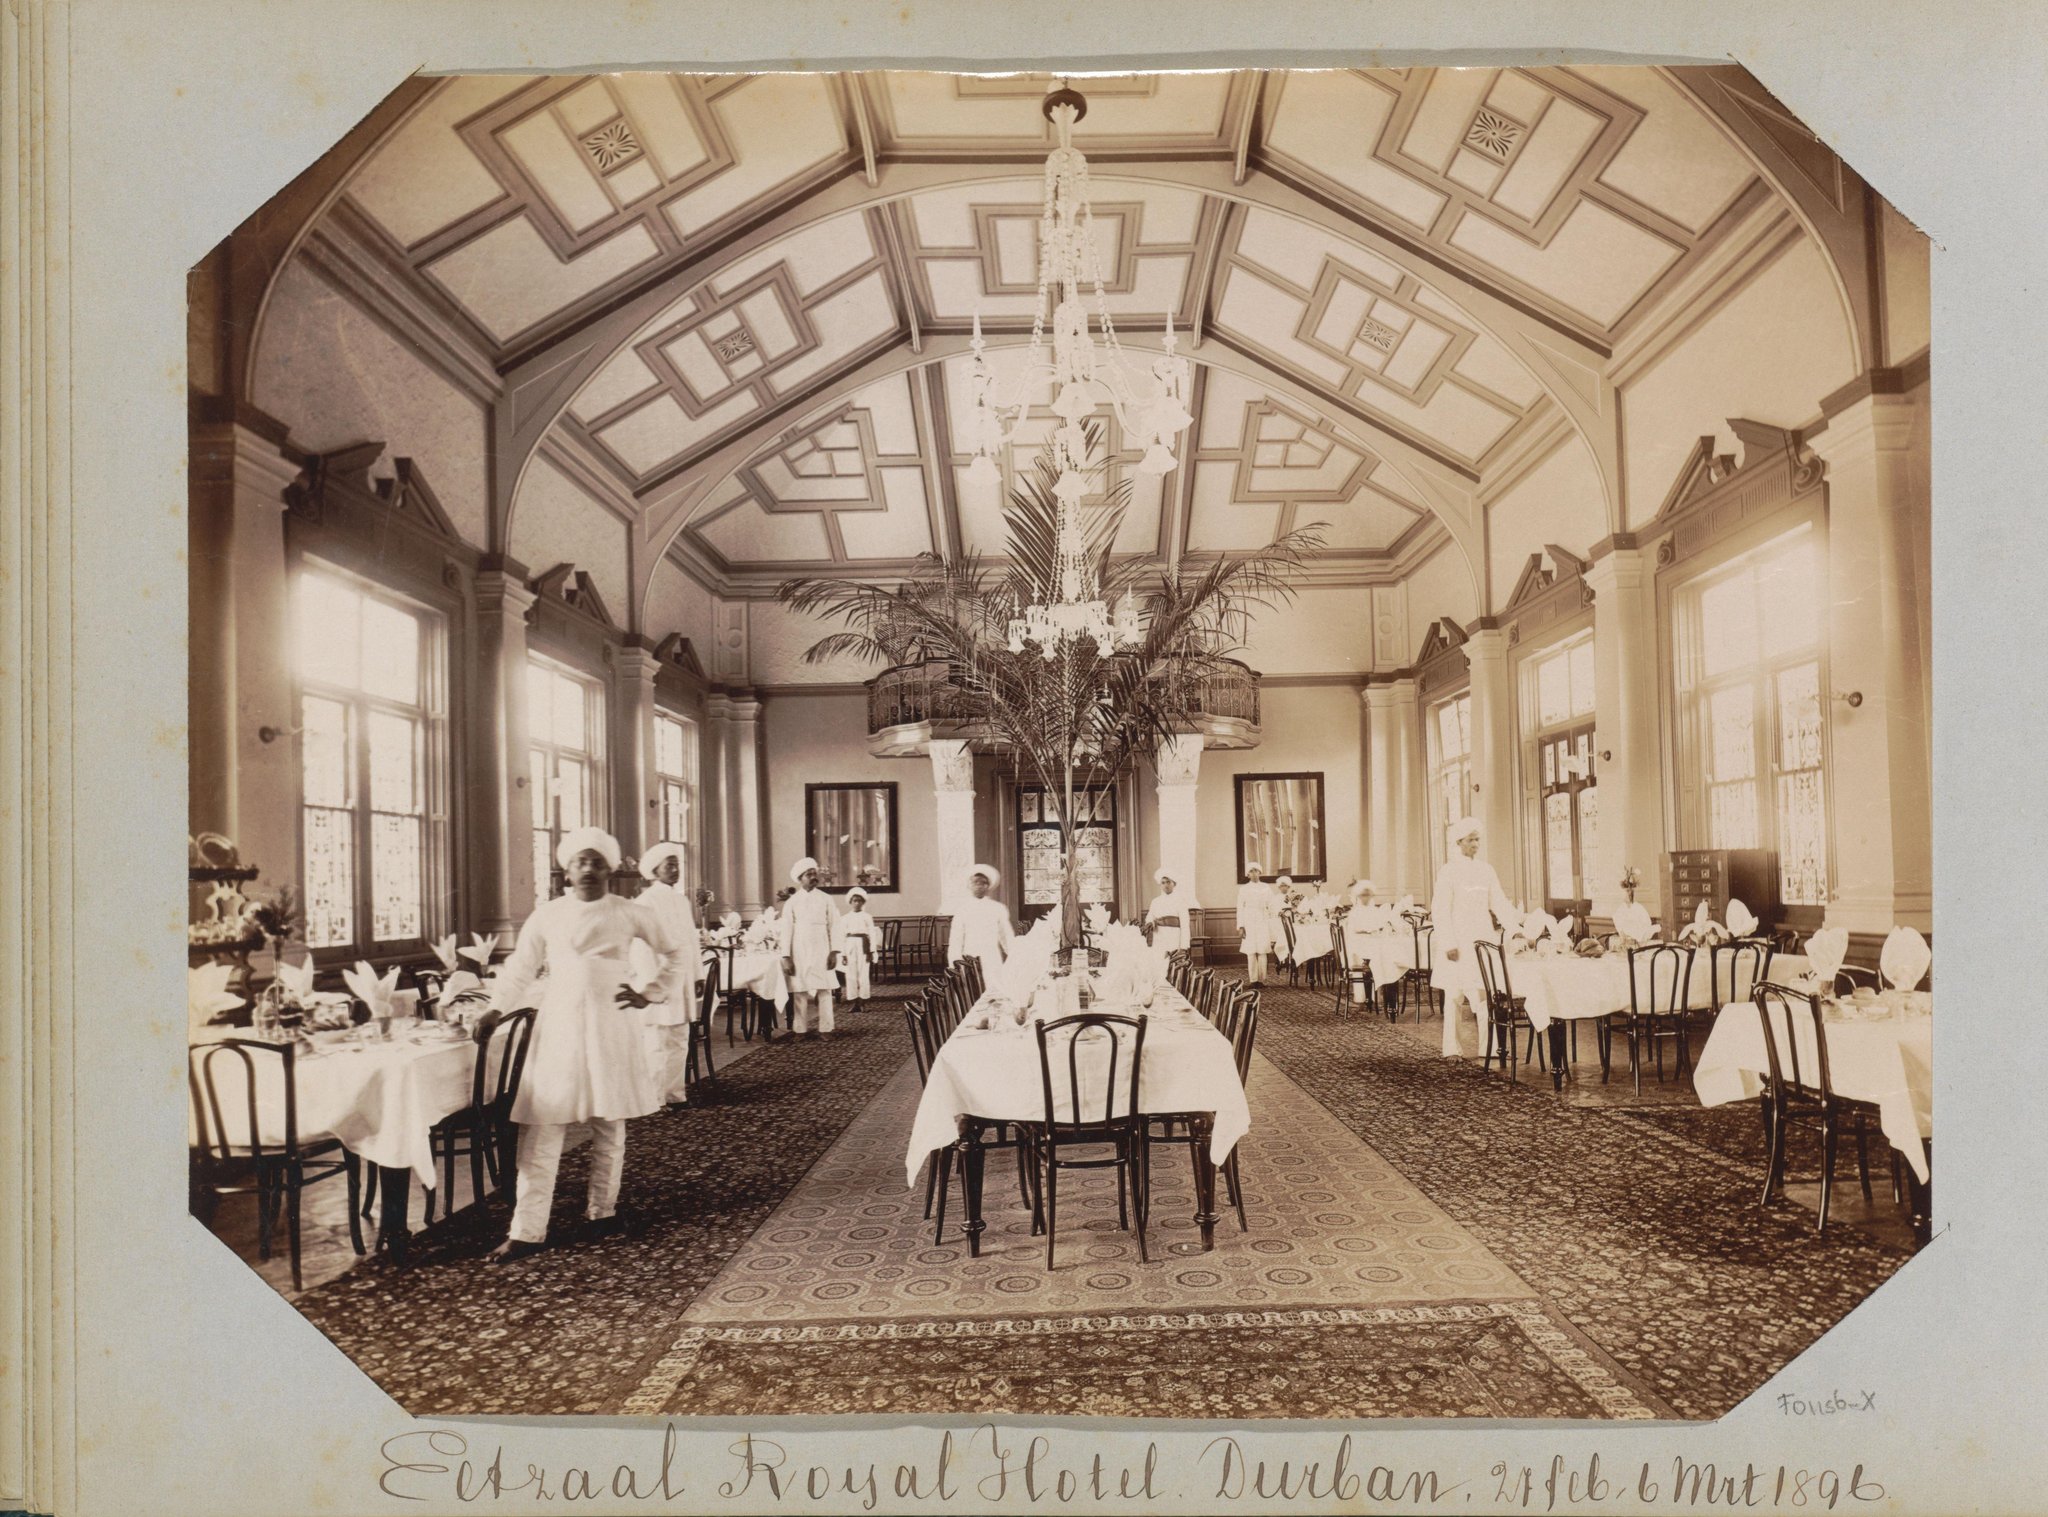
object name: album leaf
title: Interieur van de eetzaal in Royal Hotel te Durban, Zuid-Afrika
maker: Anonymous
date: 1896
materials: photographic support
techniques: albumen print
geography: durban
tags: hotel, hostelry, inn, dining-room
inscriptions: annotation: ‘Eetzaal Royal HOtel, Durban, 27 feb - 6 mrt 1896’